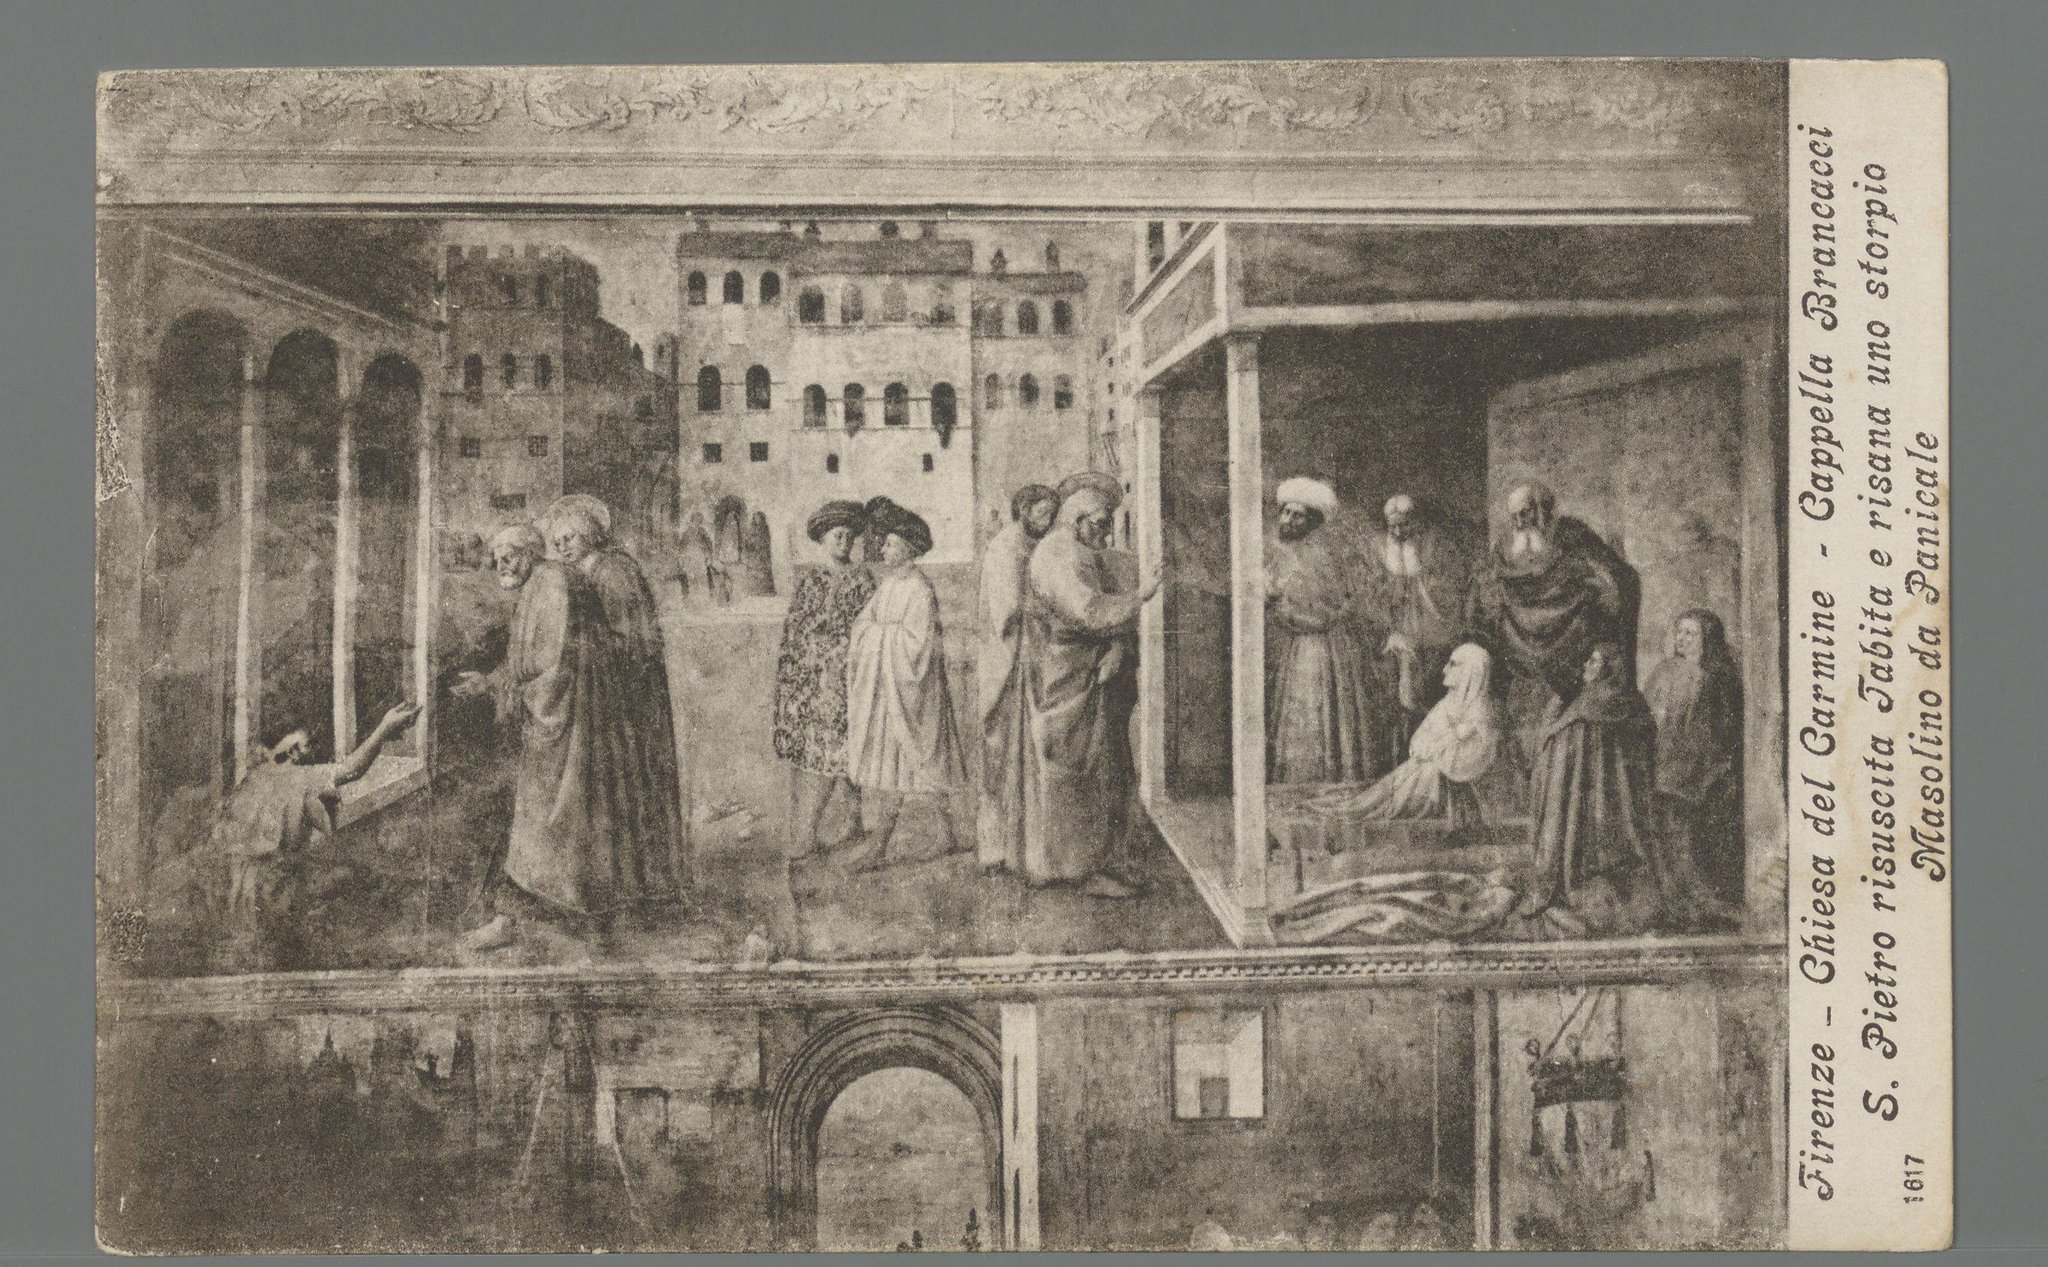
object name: photomechanical print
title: Firenze - Chiesa del Carmine - Cappella Brancacci. S. Pietro risuscita Tabita e risana uno storpio Masolino da Panicale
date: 1906-1930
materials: cardboard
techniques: photograph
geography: florence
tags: picture, painting, church (exterior) - qq - small church, chapel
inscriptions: collector's mark: ‘AFE v S’, monogram